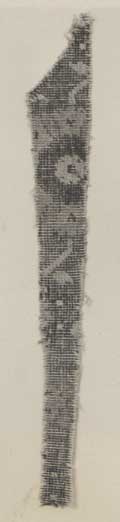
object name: carpet fragment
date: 1501-1600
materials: wool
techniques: asymmetrically knotted pile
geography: egypt